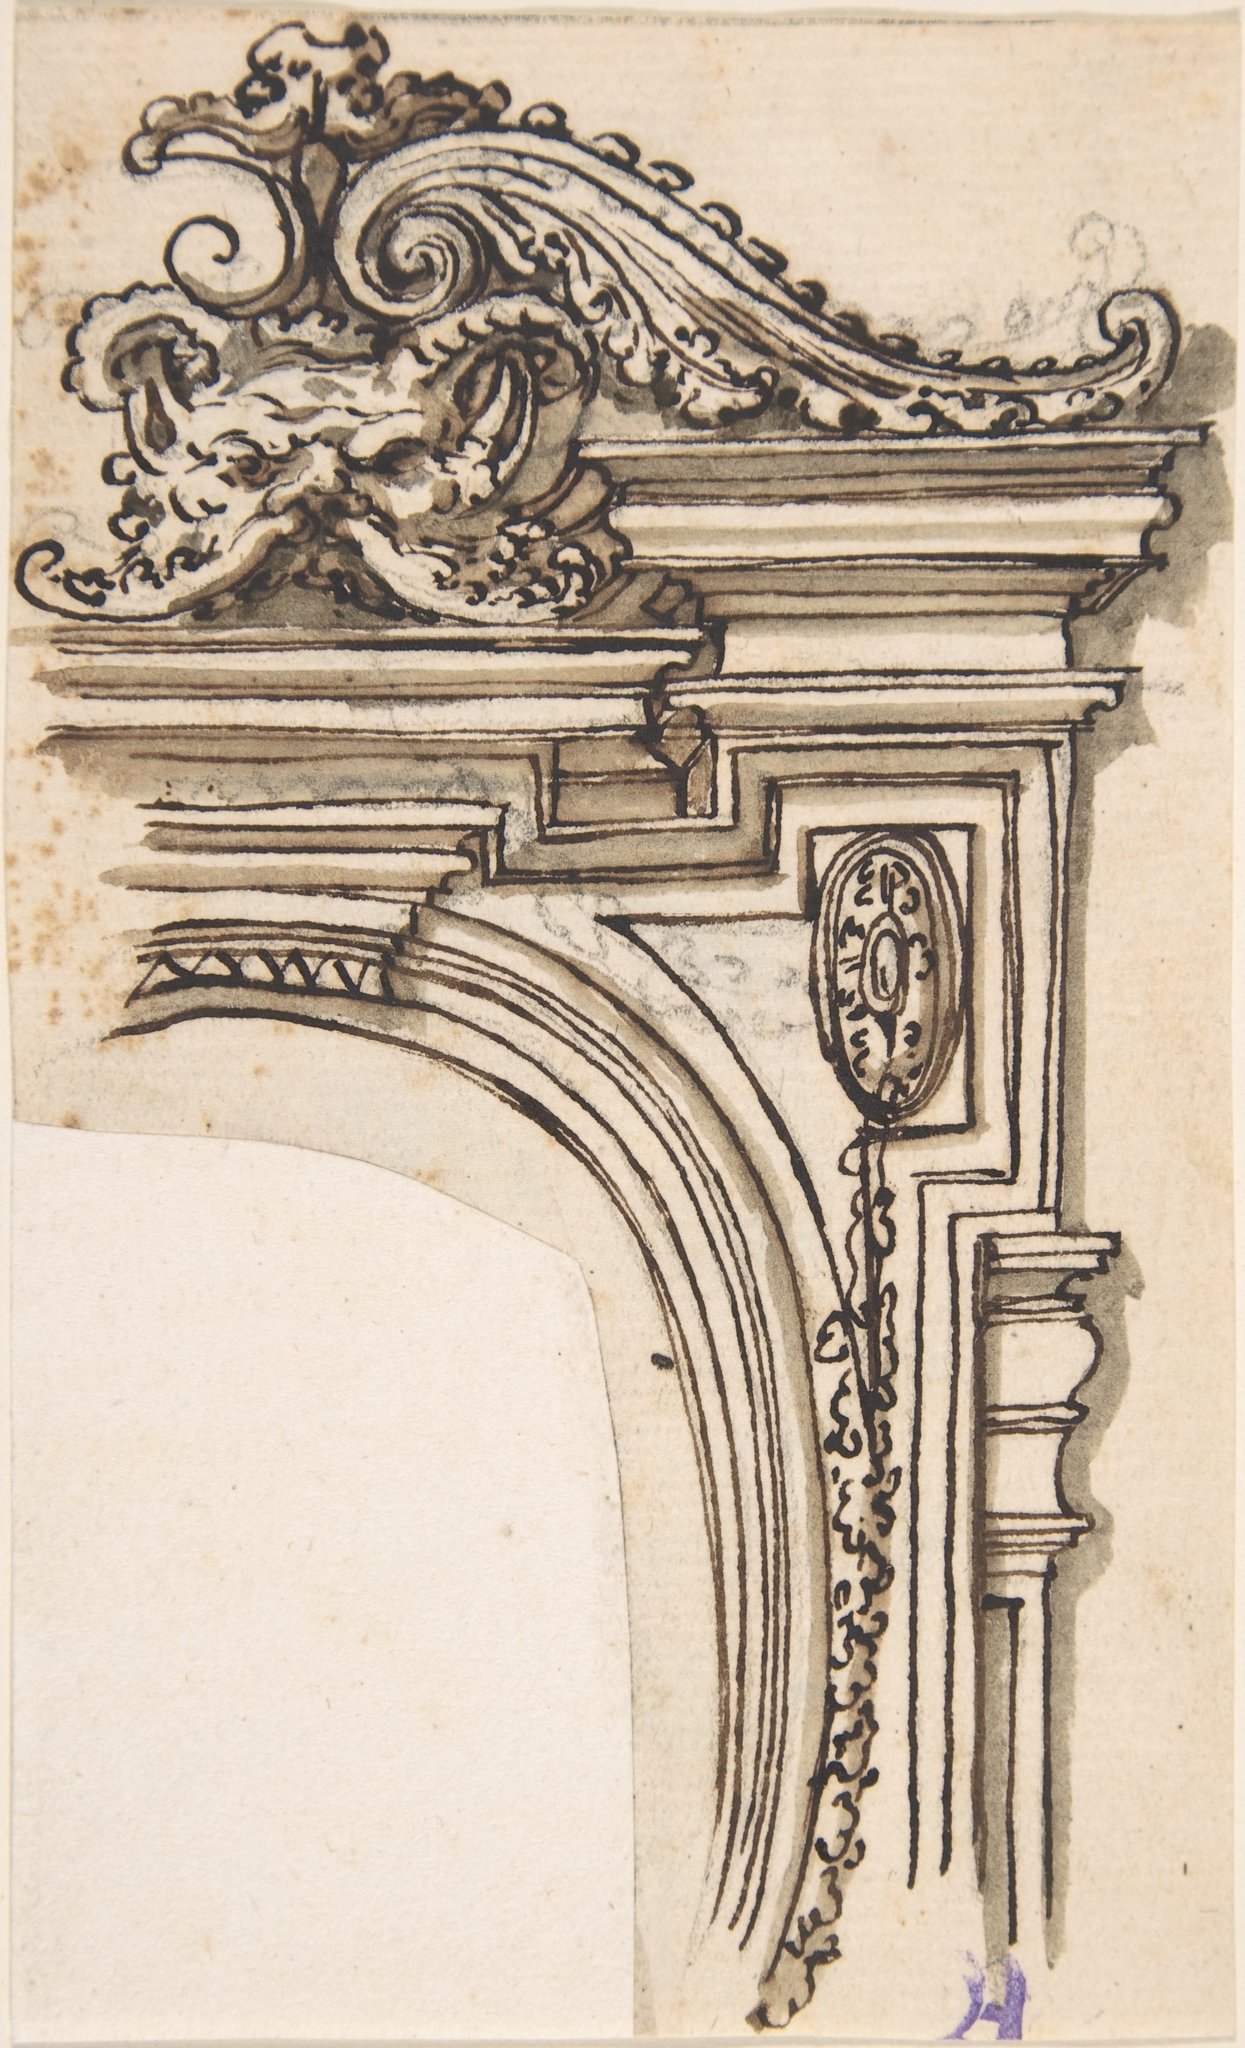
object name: drawing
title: Fragment of Frame Design (recto); Sketch of a Man's Head in Profile (verso)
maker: anonymous, italian, 17th or 18th century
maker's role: artist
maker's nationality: italian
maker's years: 1600-1799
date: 1601-1800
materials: graphite, ink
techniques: brush, pen, wash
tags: architecture,heads,men,profiles